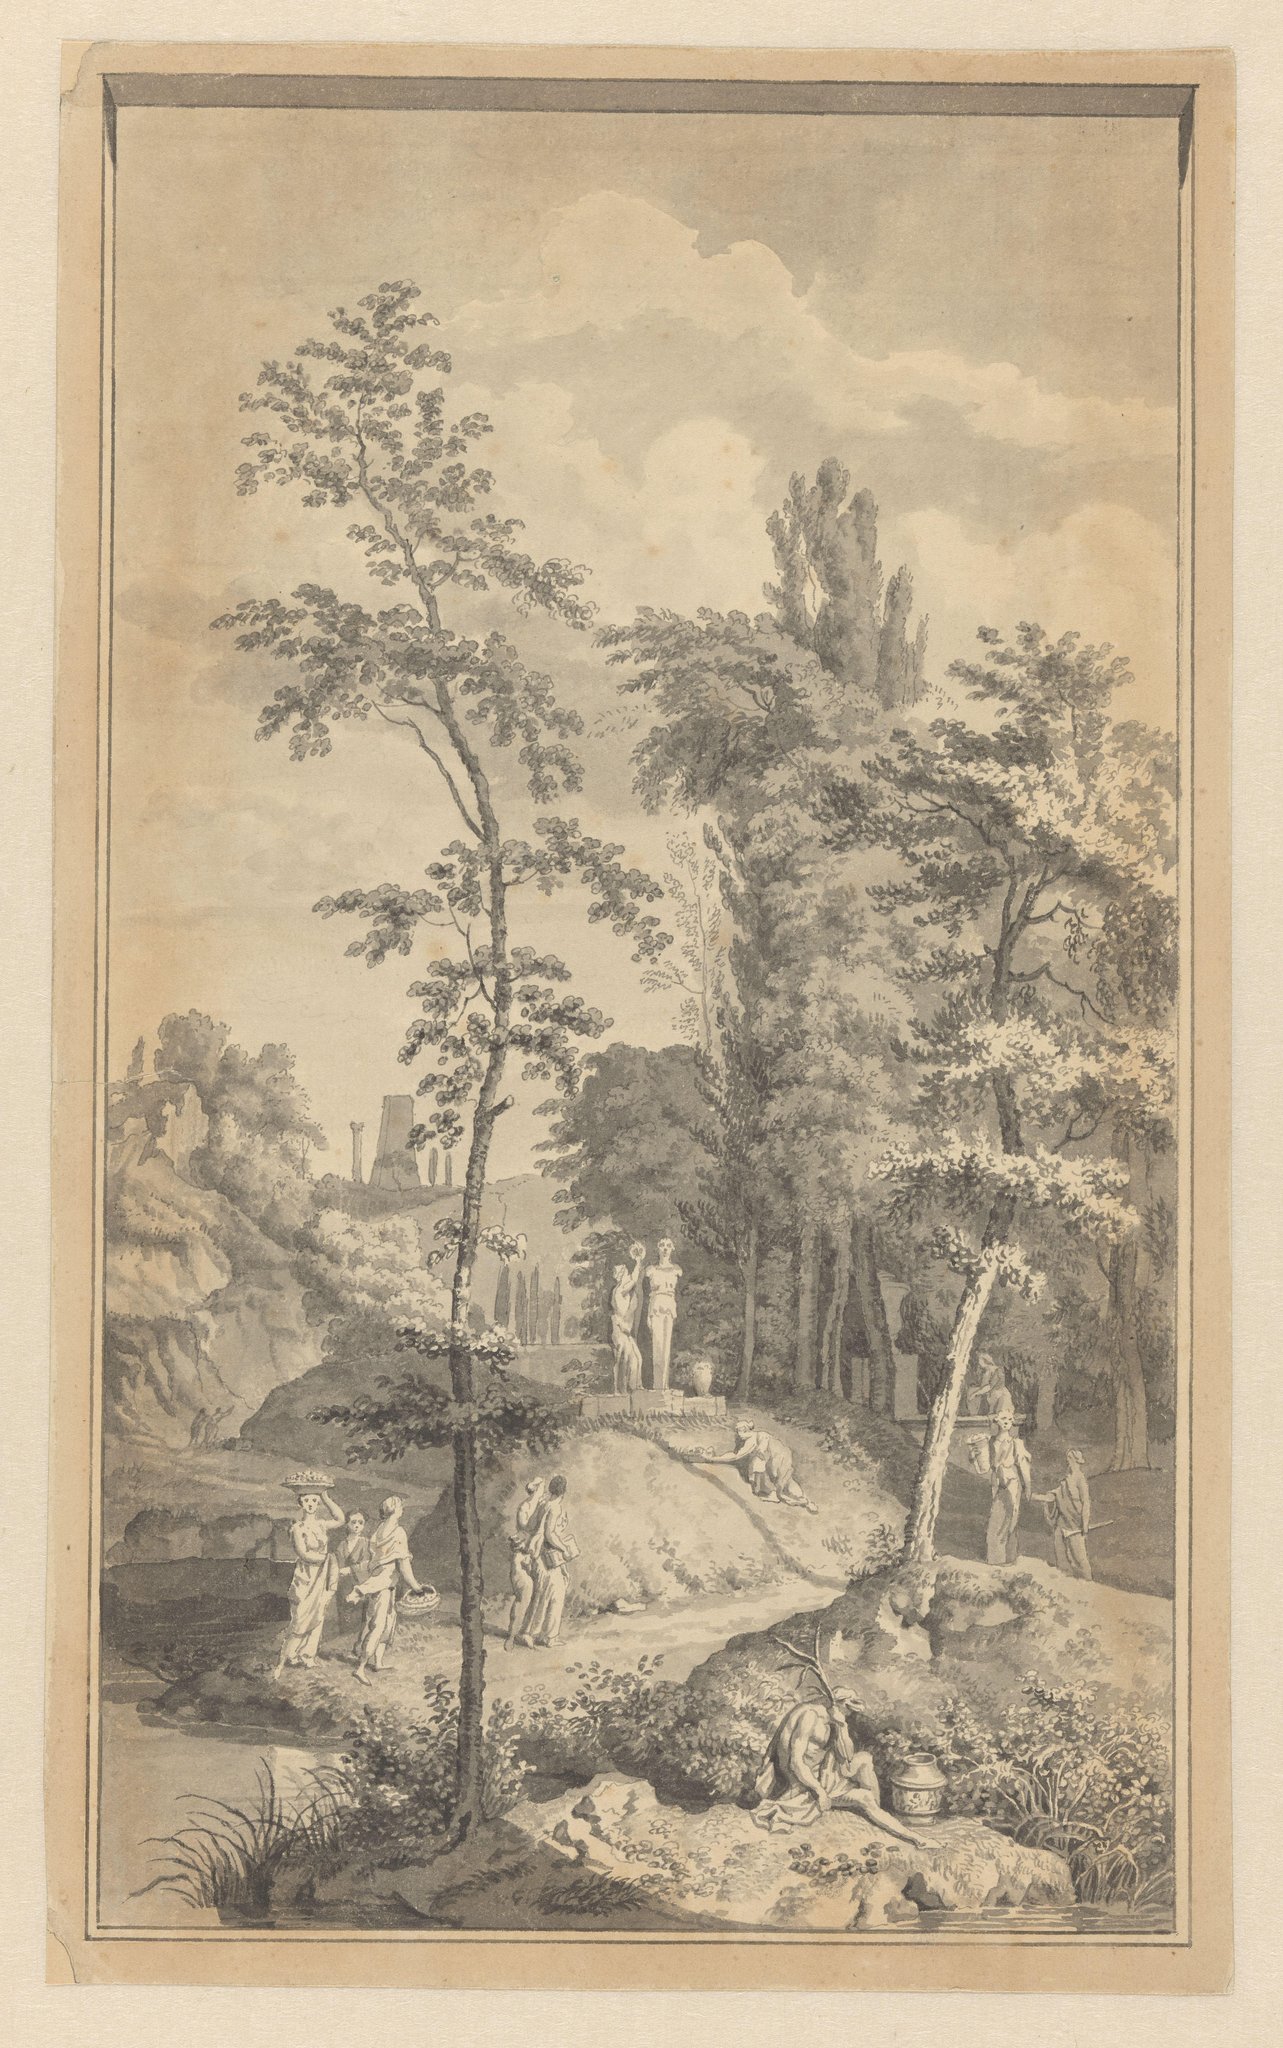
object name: drawing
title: Arcadisch landschap met offerende vrouwen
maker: Anonymous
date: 1700-1800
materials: ink, paper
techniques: brush, pen